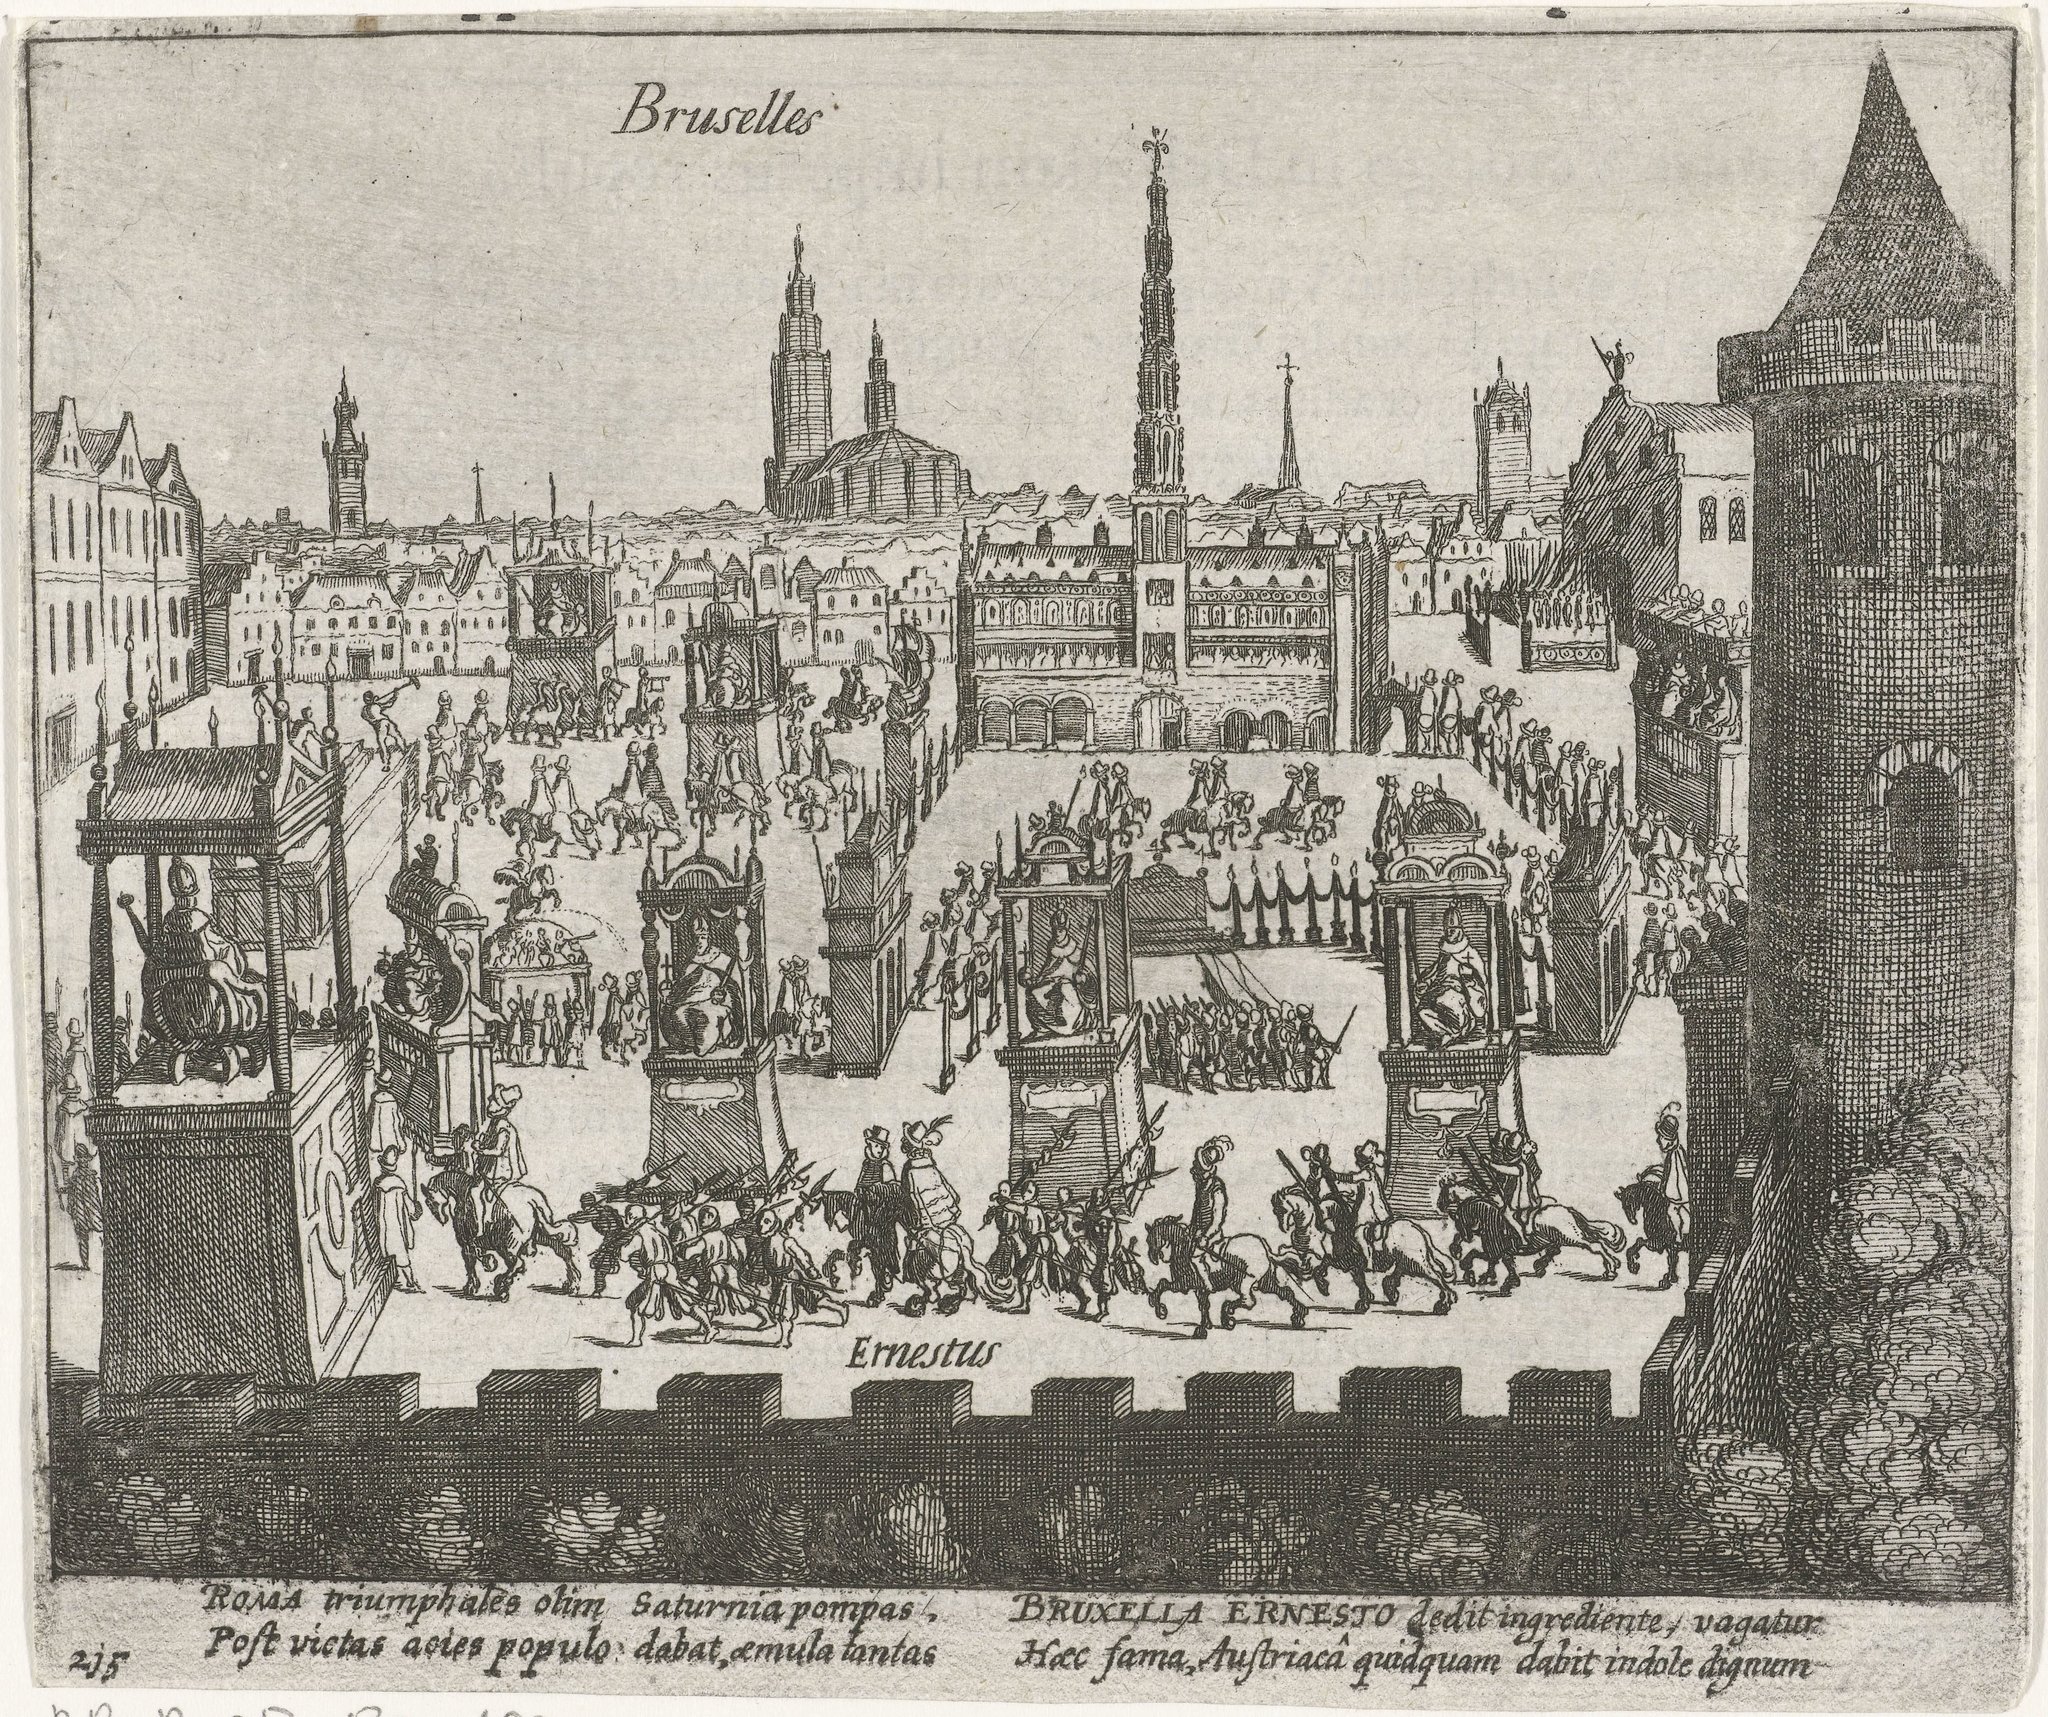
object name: print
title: Intocht van Ernst van Oostenrijk te Brussel, 1594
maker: simon frisius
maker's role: print maker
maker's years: 1570-1628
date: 1613-1615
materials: paper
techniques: etching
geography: northern netherlands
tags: triumphal entry and public reception, pageant, 'entrée solennelle', 'joyeuse entrée', brussels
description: Intocht van aartshertog Ernst van Oostenrijk, aangesteld als landvoogd over de Zuidelijke Nederlanden, te Brussel, 30 januari 1594. De stoet trekt langs triomfpoorten en Standbeelden van Oostenrijkse keizersopgesteld op de Grote Markt te Brussel. Met onderschrift van 4 regels in het Latijn. Genummerd 215. Bedrukt op achterzijde met tekst in het Latijn.